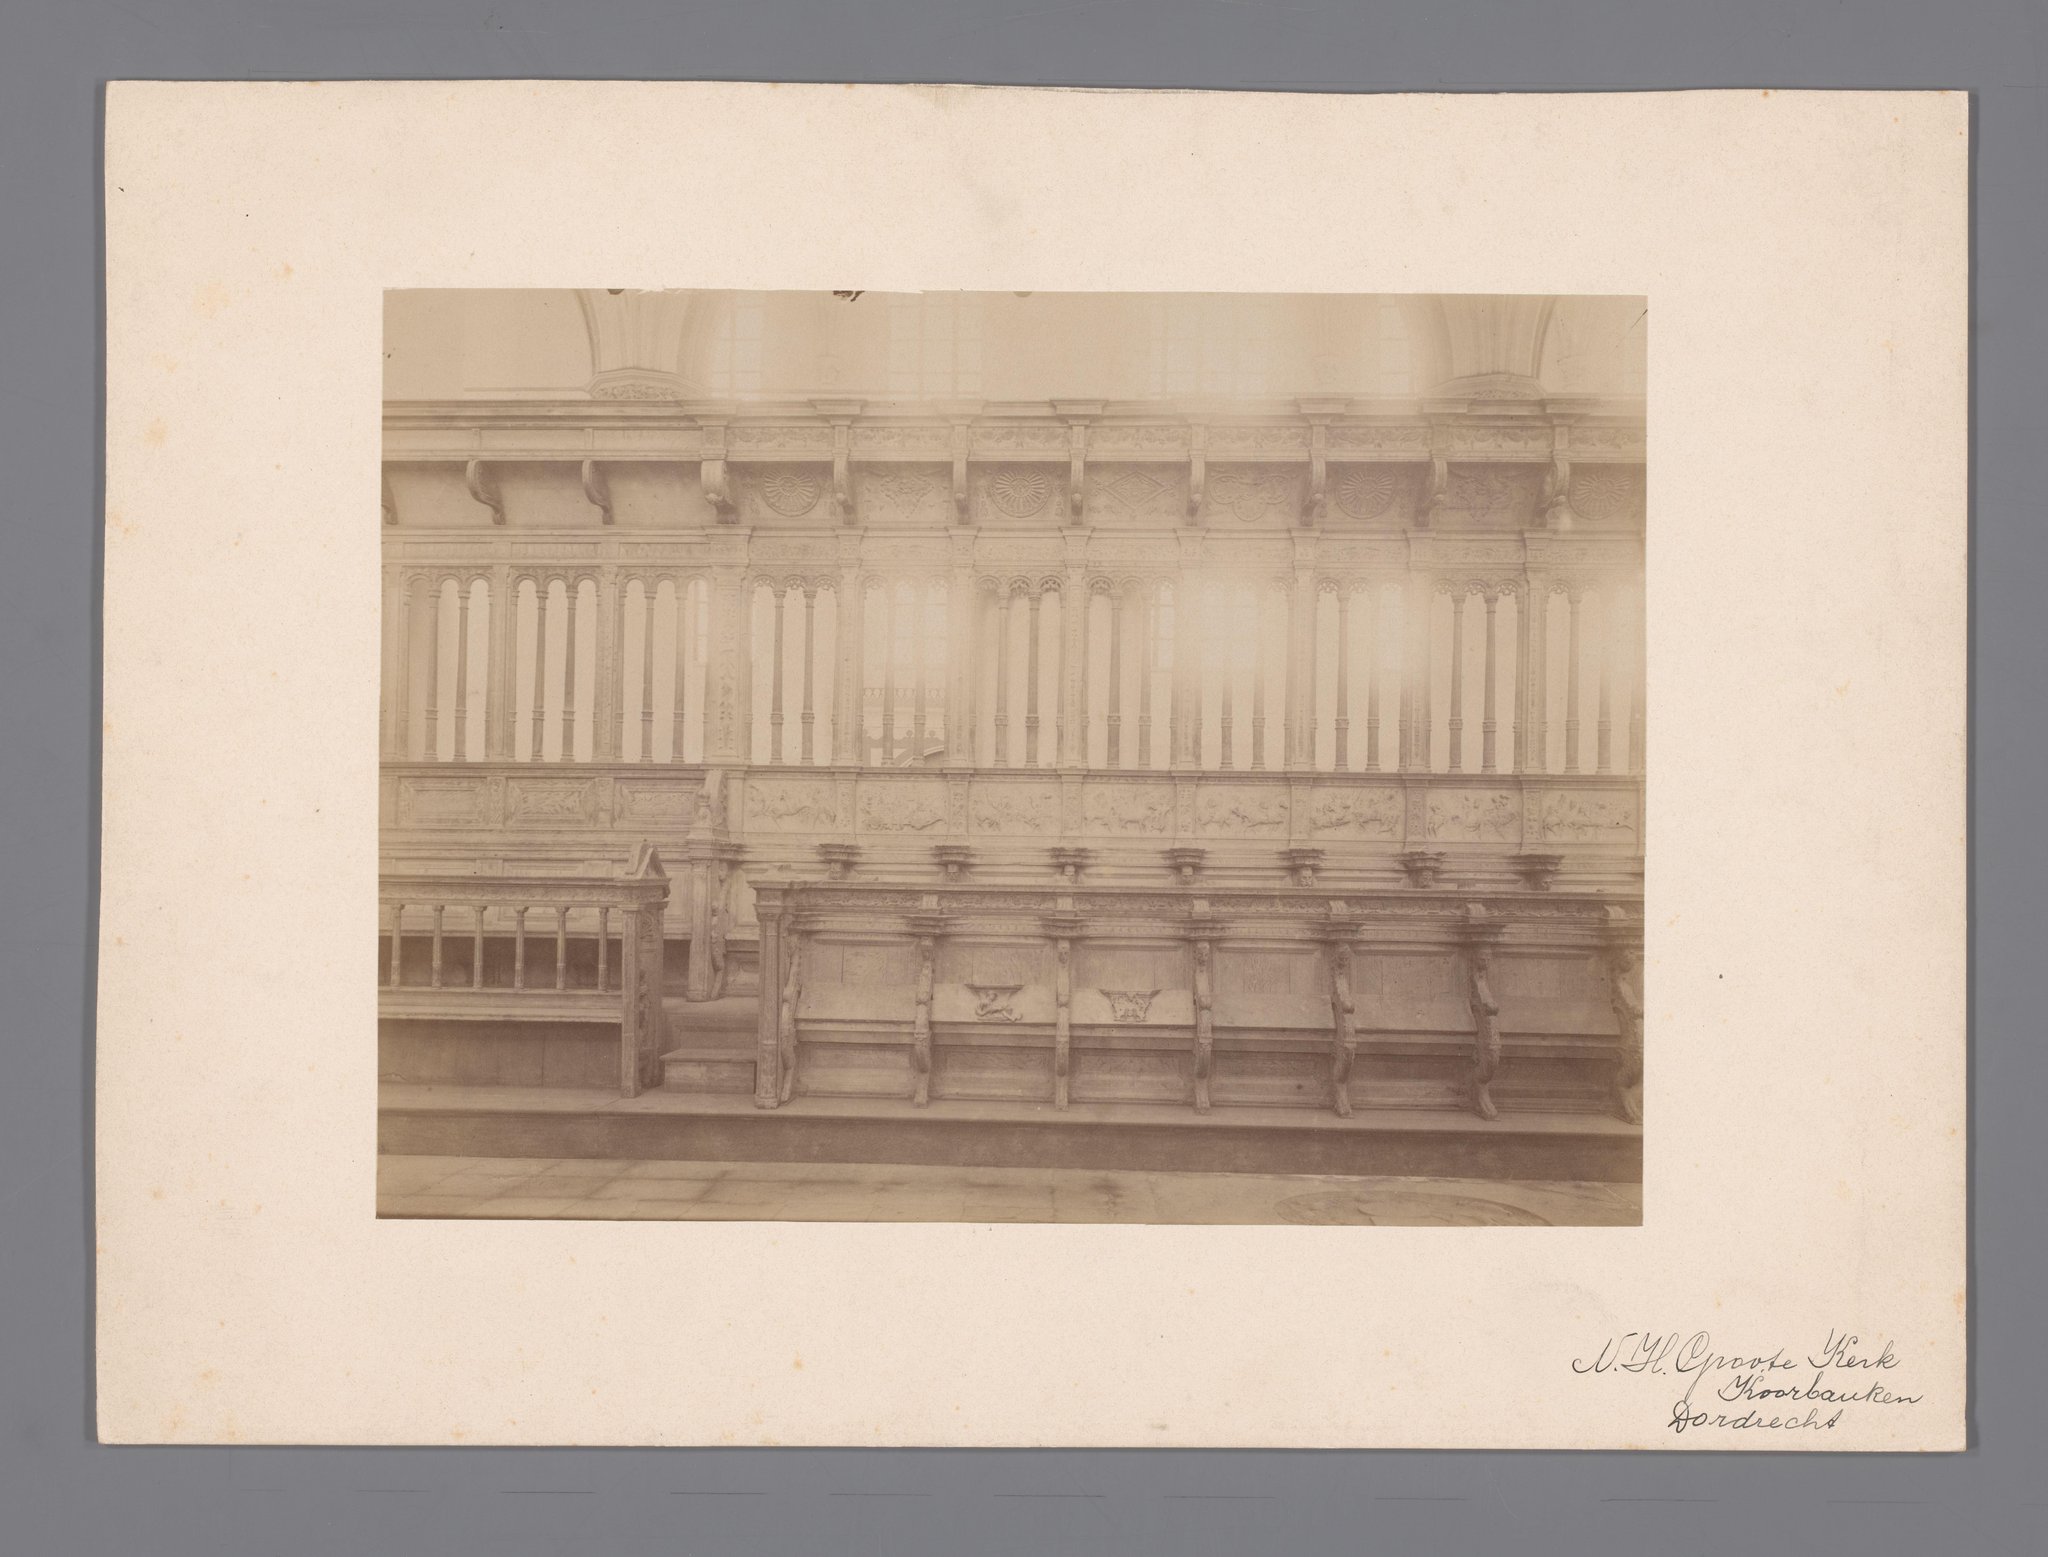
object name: photograph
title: Koorbanken in de Grote of Onze-Lieve-Vrouwenkerk te Dordrecht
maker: anoniem (monumentenzorg)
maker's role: fotograaf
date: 1880-1910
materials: cardboard, photographic support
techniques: albumen print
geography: grote of onze-lieve-vrouwekerk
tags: interior of church, seats of the clergy, choir-stalls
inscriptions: annotation: ‘N.H. Groote Kerk/ Koorbanken/ Dordrecht’, annotation: ‘Dordrecht/ koorbanken’